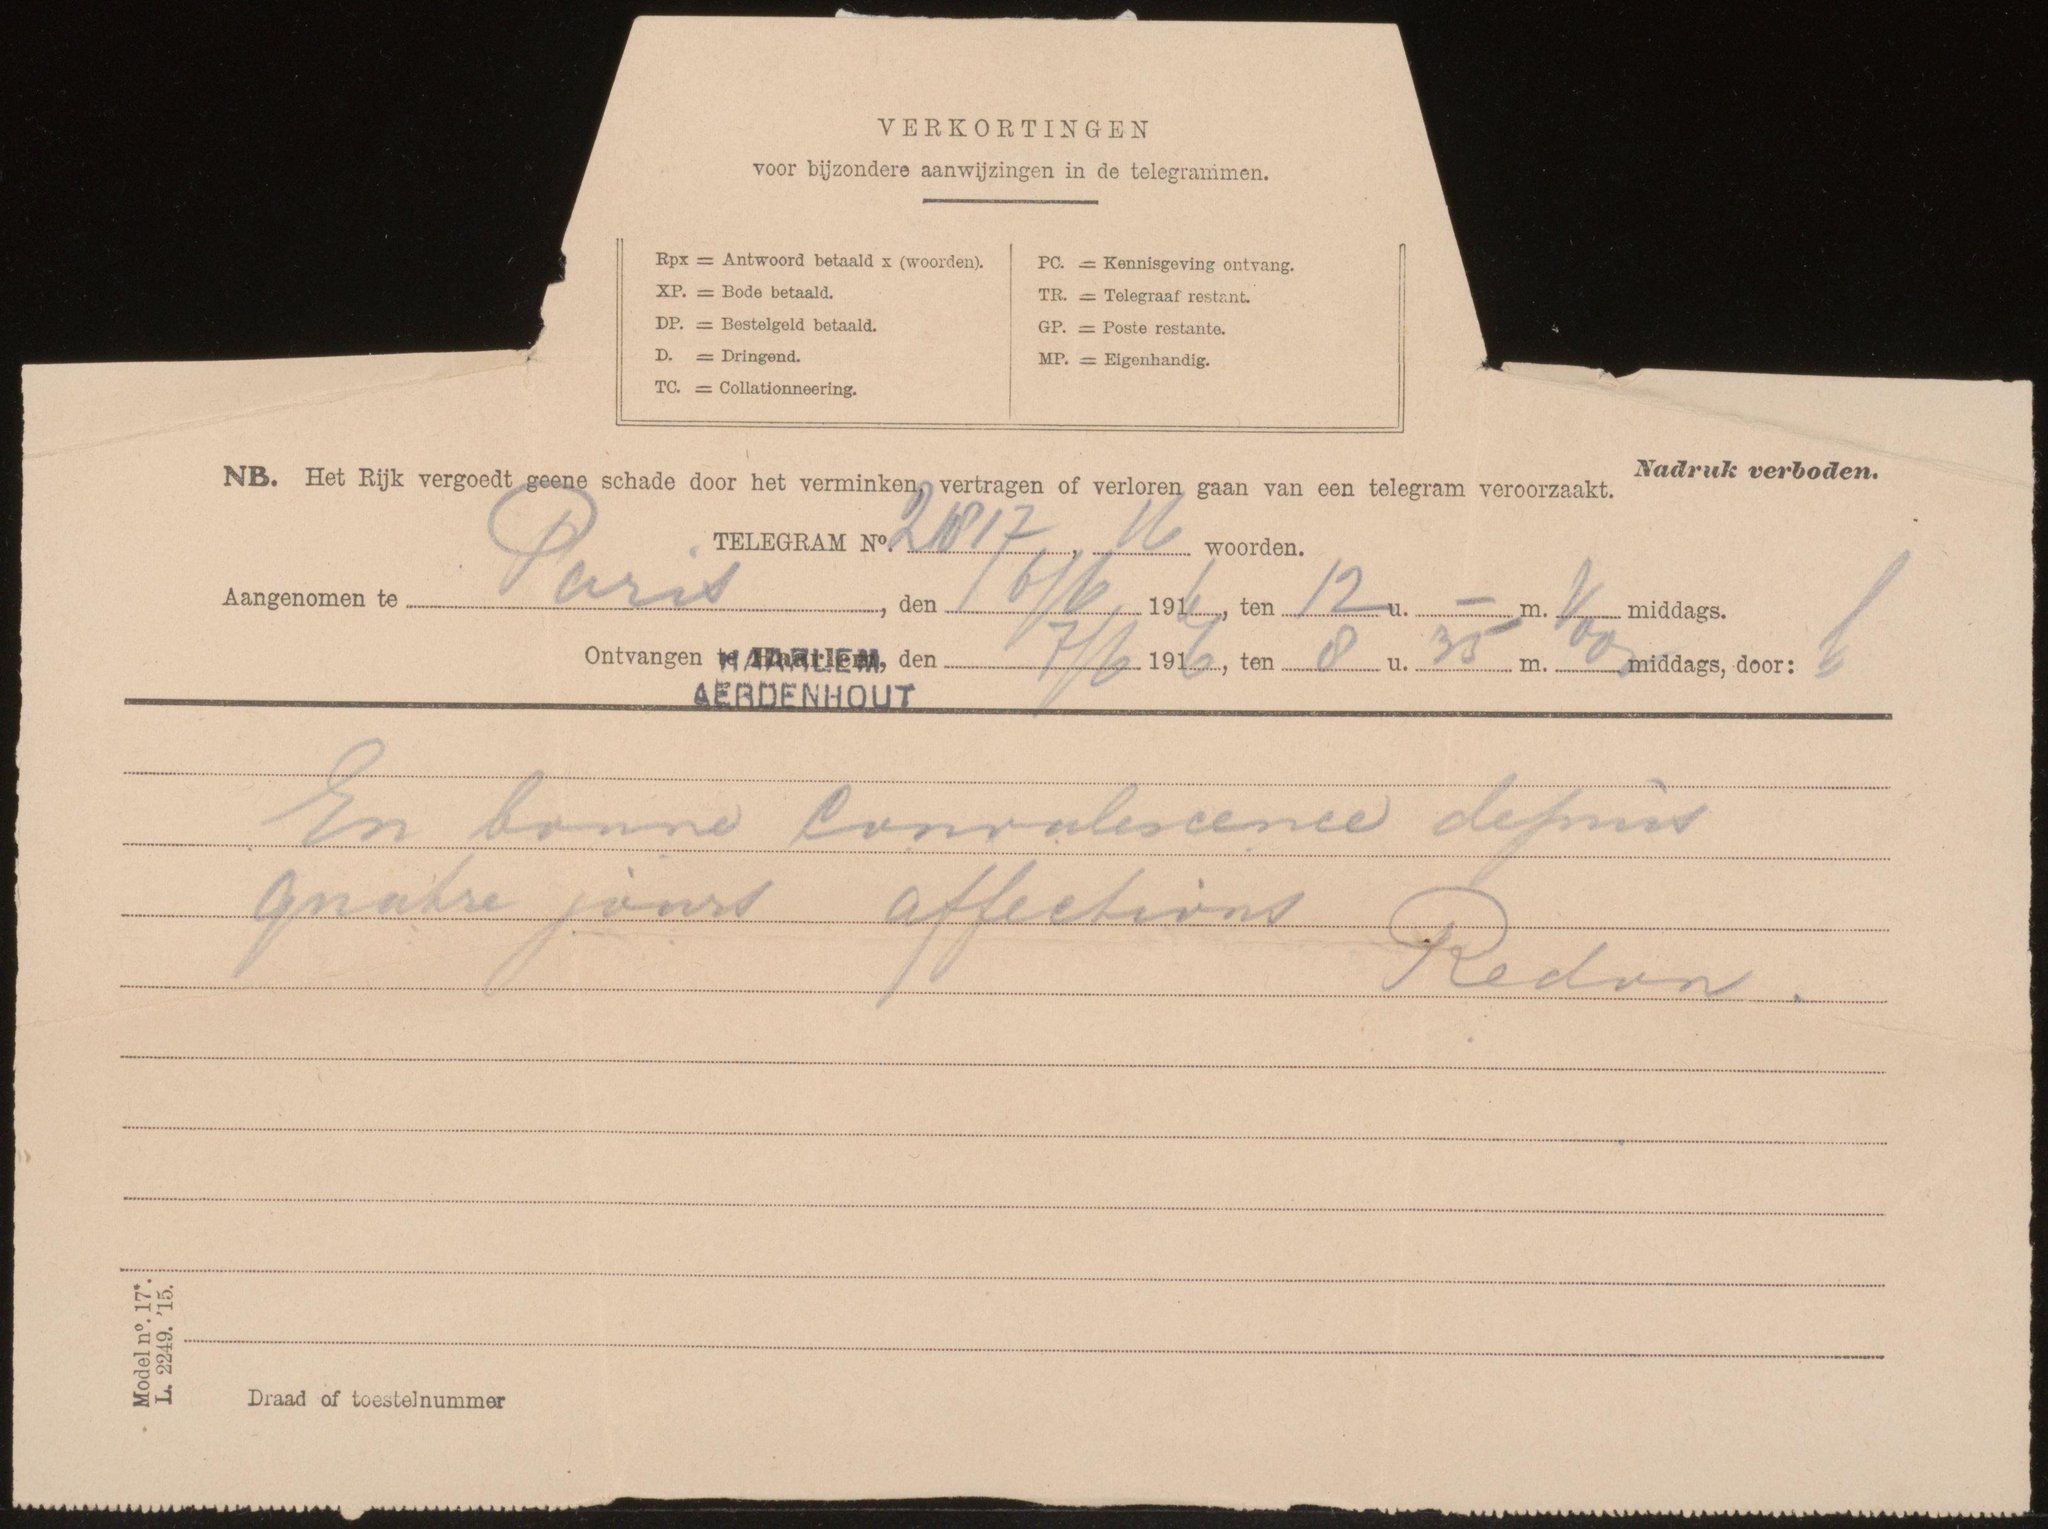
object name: telegram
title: Telegram aan Andries Bonger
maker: odilon redon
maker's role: draughtsman, painter, print maker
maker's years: 1840-1916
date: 1916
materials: paper, pencil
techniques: printing, writing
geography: paris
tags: amsterdam, andries bonger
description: Telegram behoort tot een album samengesteld door weduwe Françoise W.M. Barones van der Borch van Verwolde met afschriften van brieven met betrekking tot (de familie van) Odilon Redon. Het telegram werd bewaard op pagina 106.